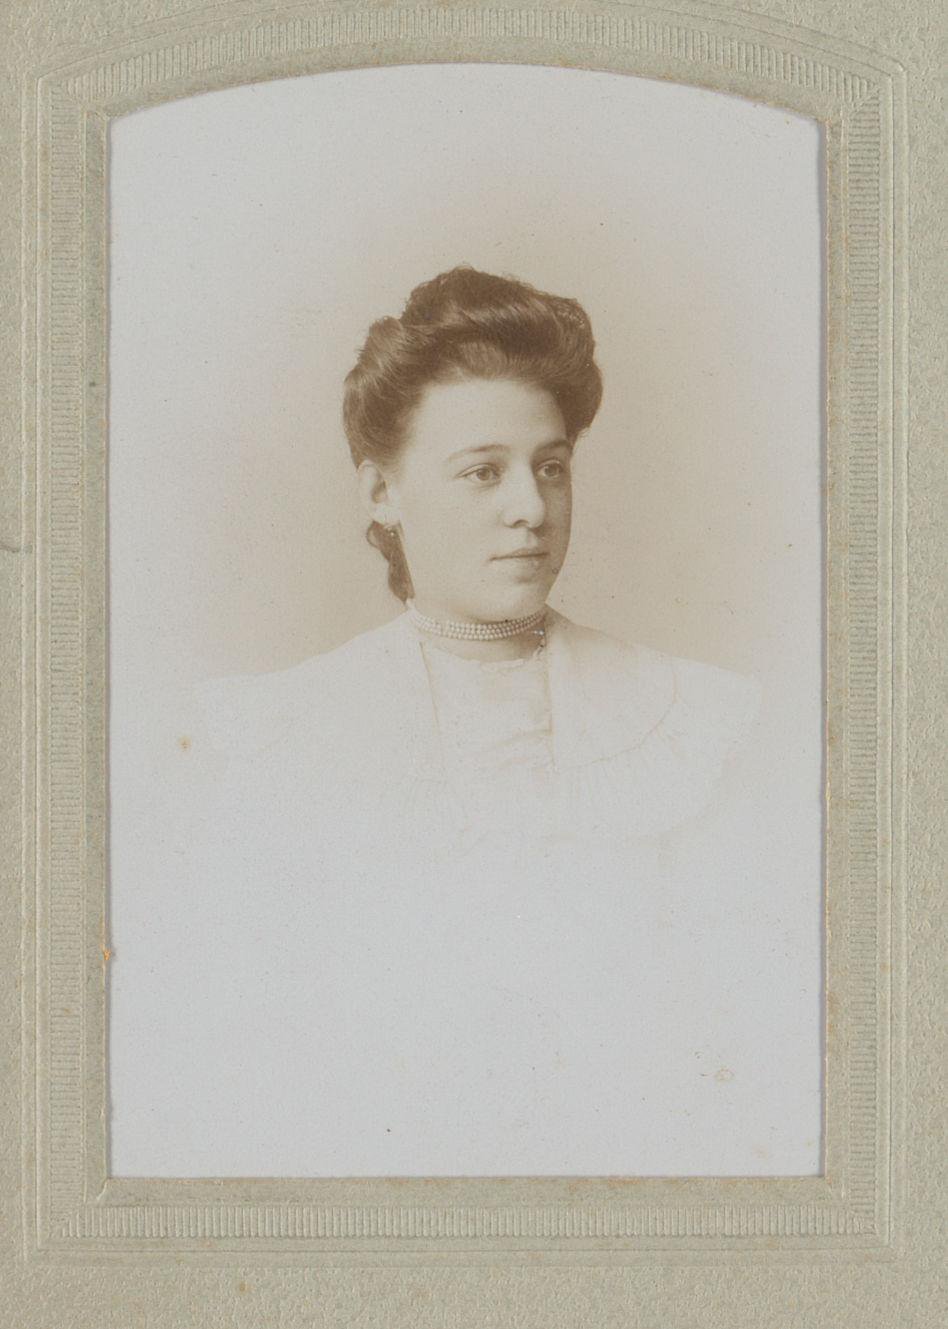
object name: photograph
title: Portret van een vrouw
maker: friedrich carel hisgen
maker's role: fotograaf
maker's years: 1846-1912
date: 1890-1910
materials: cardboard, photographic support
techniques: gelatin silver print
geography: amsterdam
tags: adult woman, historical persons